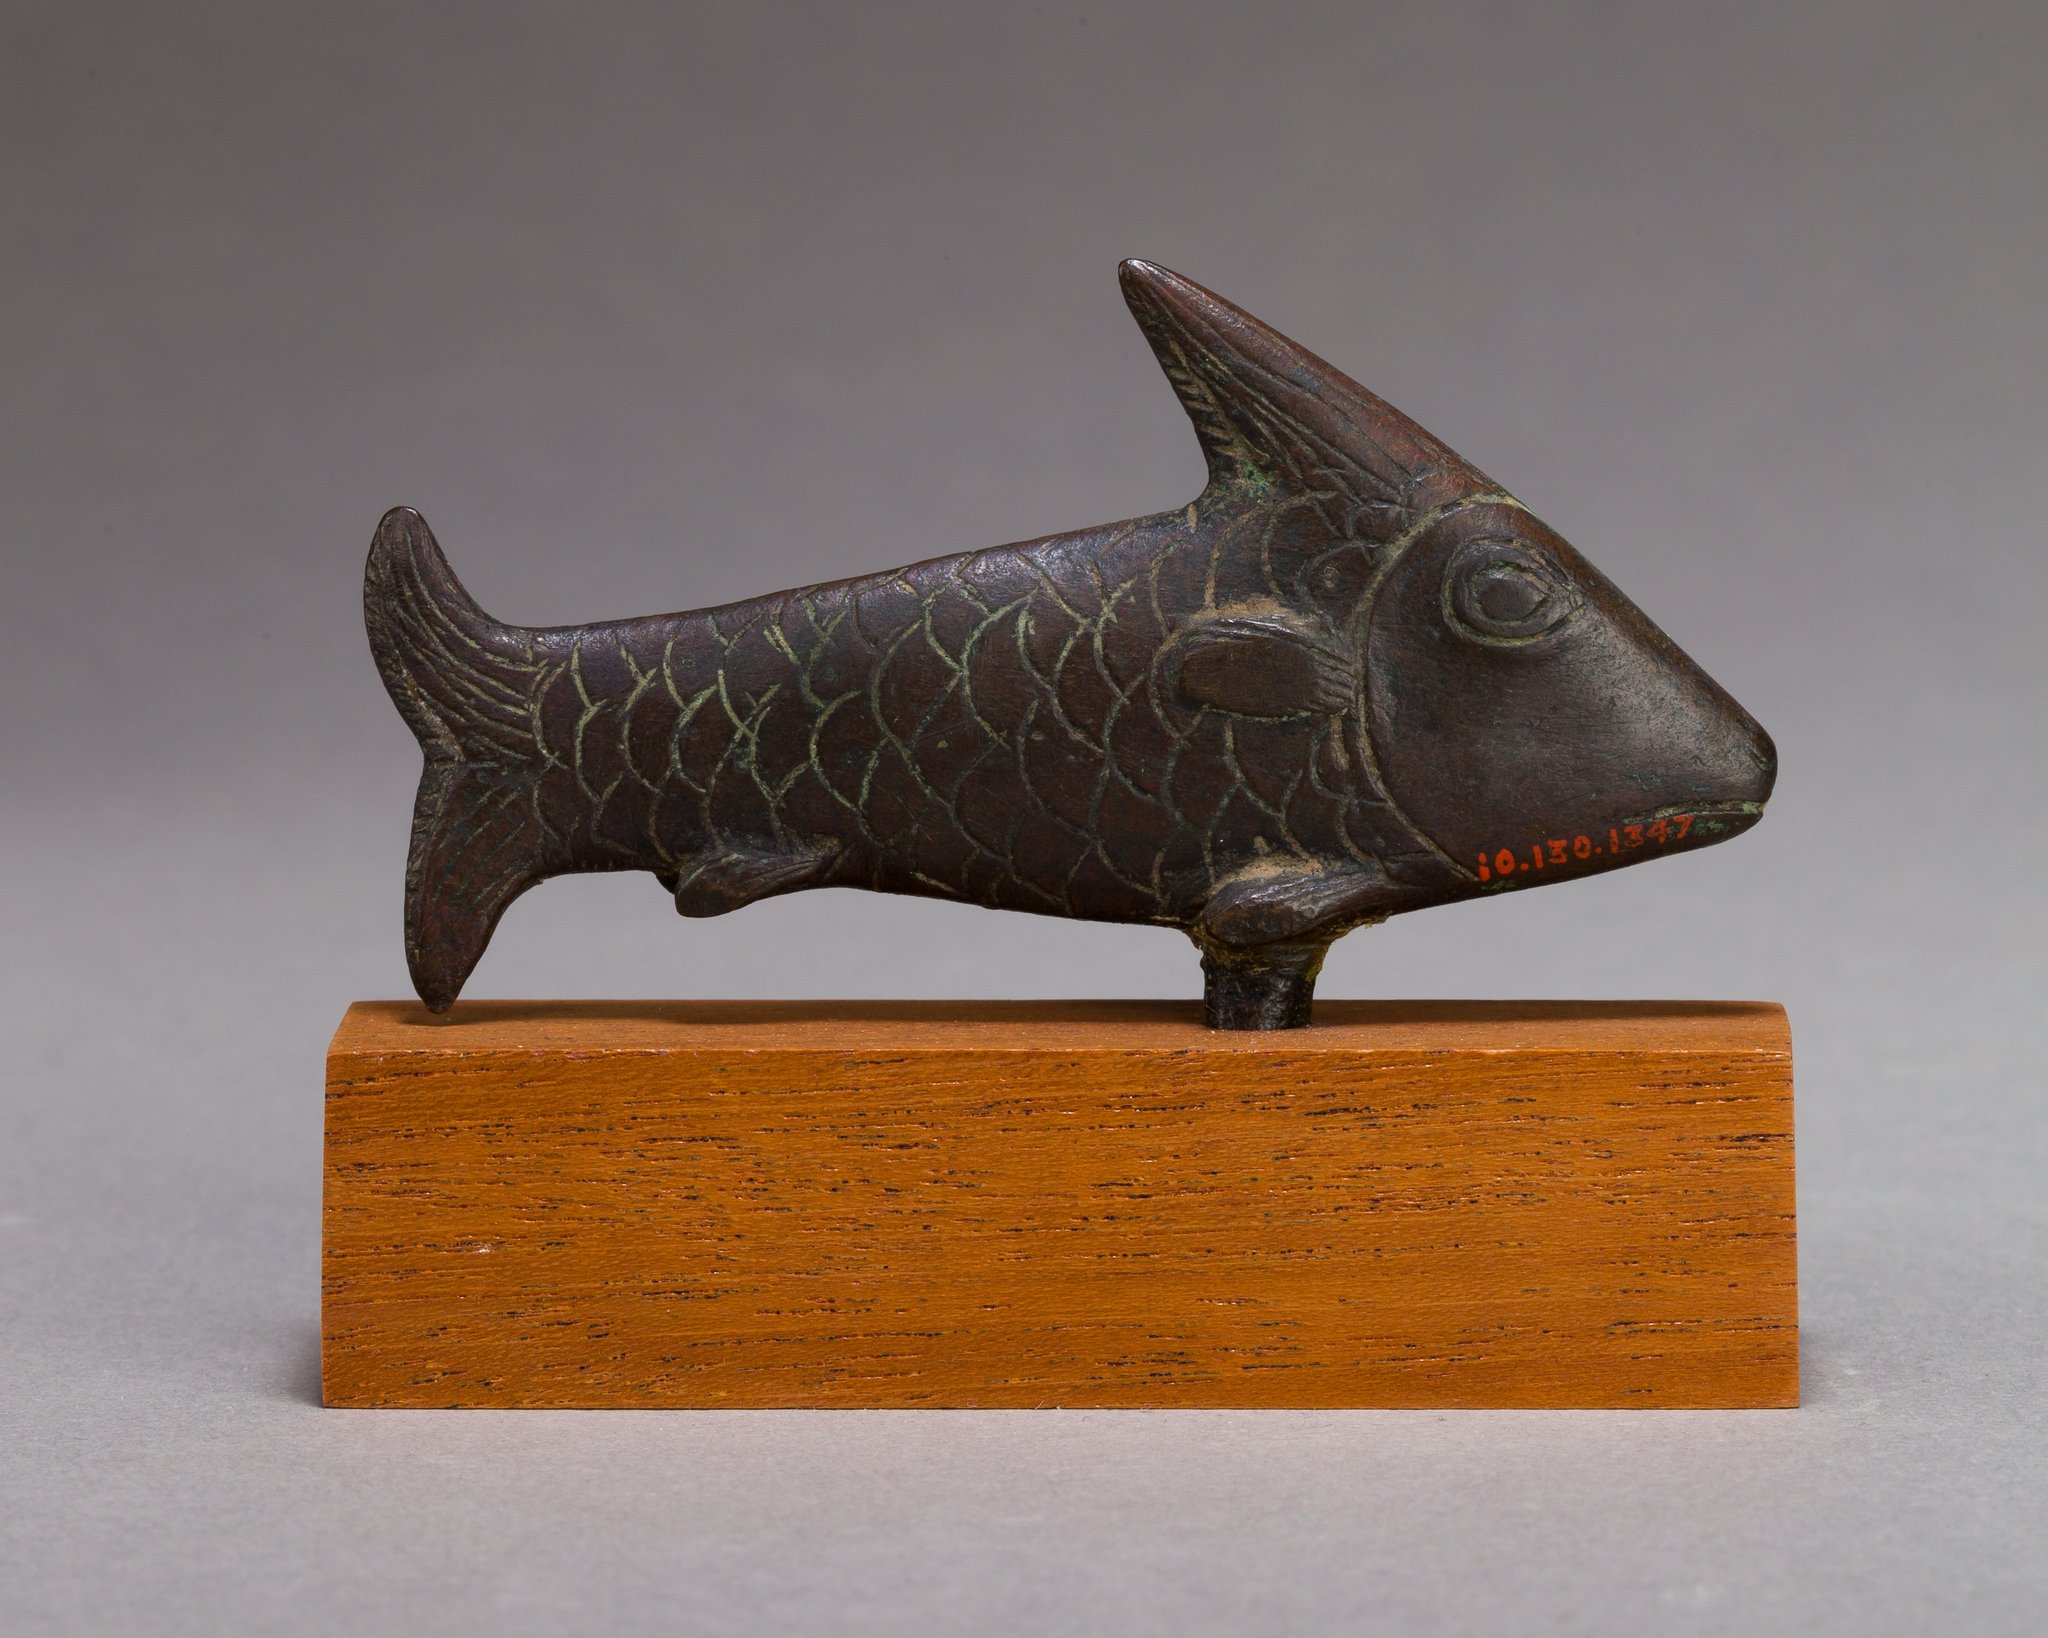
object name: figurine, lepidotus fish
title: Lepidotus fish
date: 664-630 BCE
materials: metal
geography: egypt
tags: fish